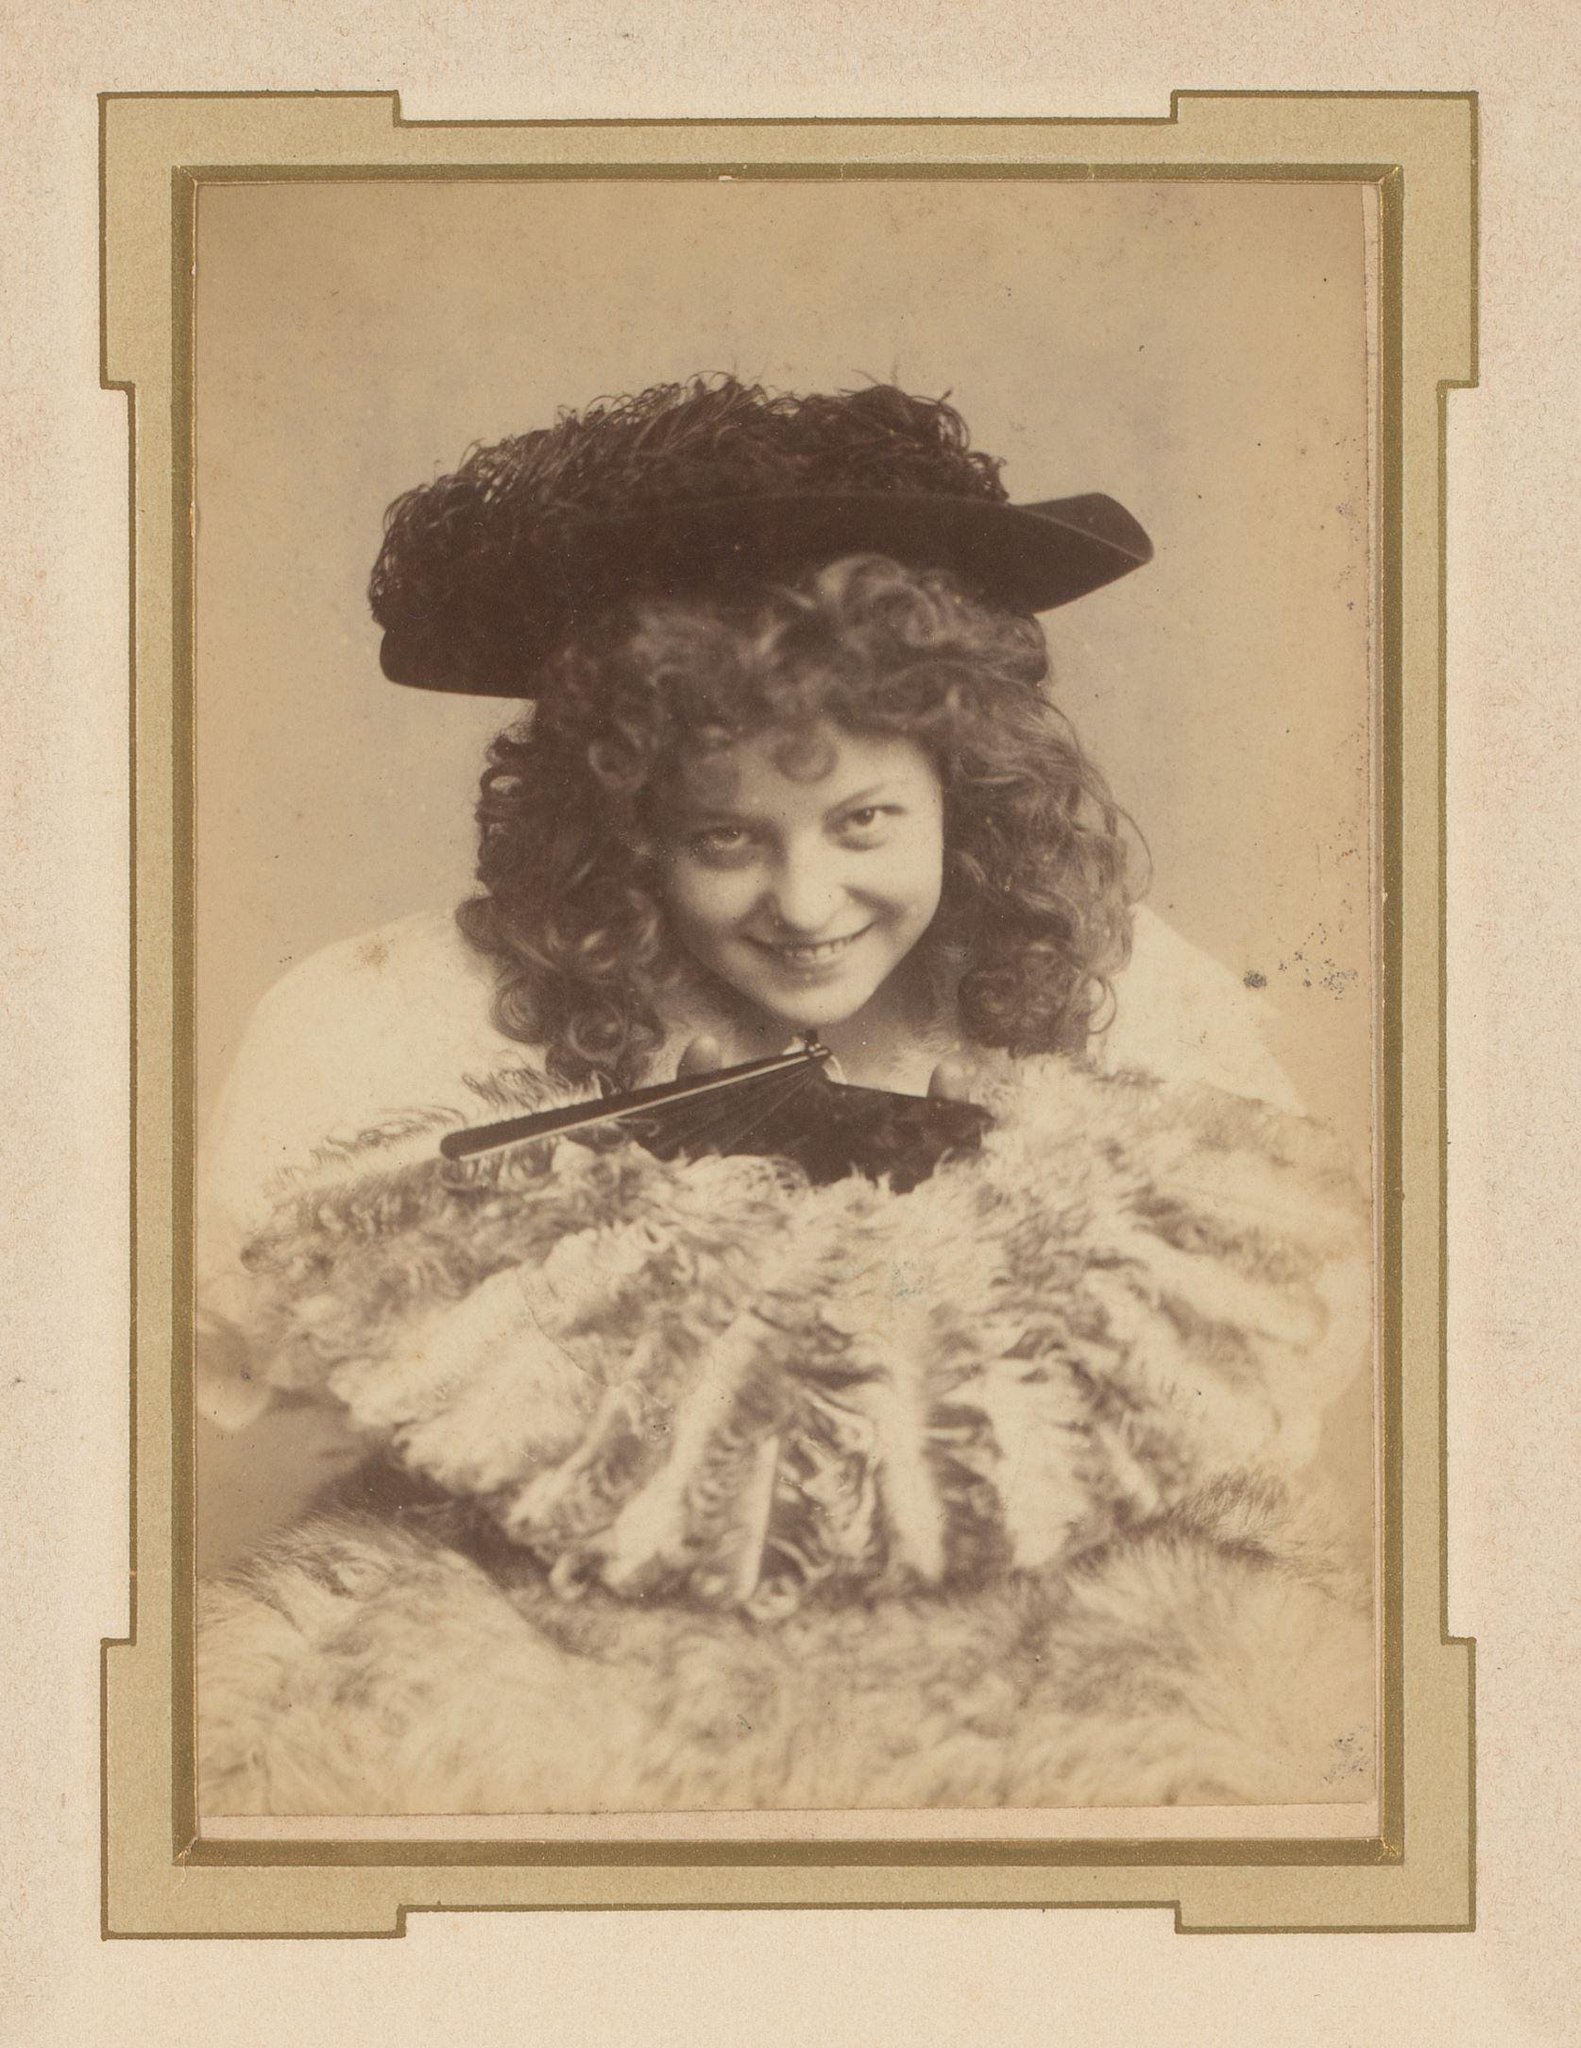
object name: album leaf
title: Portret van een jonge vrouw met hoed en waaier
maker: Anonymous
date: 1870-1900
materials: cardboard, photographic support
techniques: albumen print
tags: adolescent, young woman, maiden, historical persons - bb - woman, fan, head-gear: hat